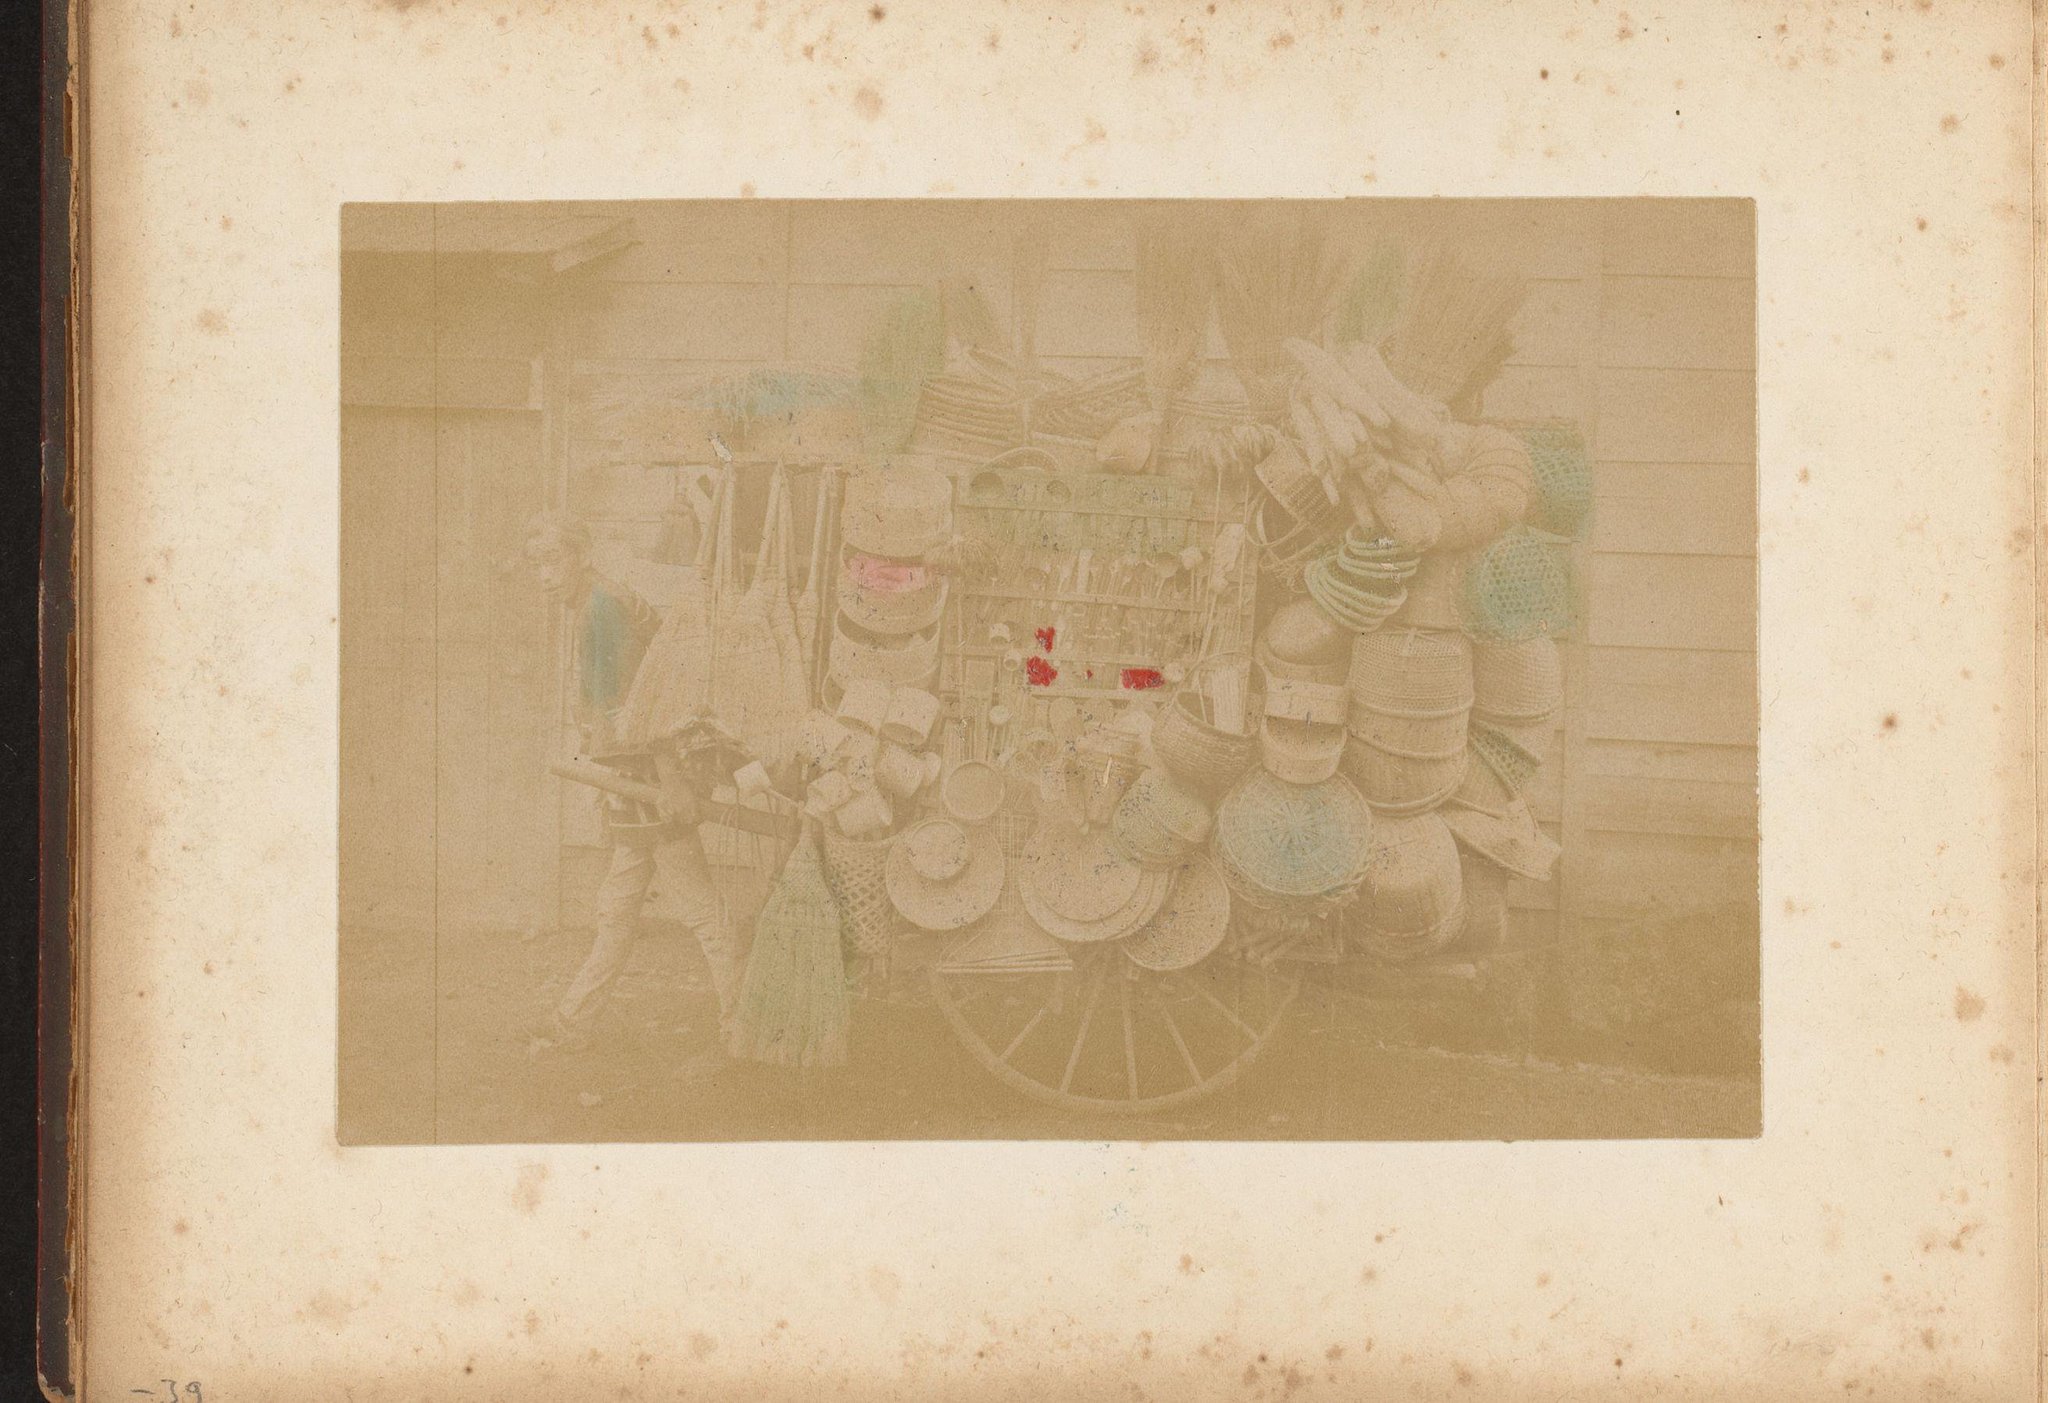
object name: album leaf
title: Man met een rijdende kraam koopwaar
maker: Anonymous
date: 1851-1900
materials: paper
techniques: albumen print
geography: japan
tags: merchant, salesman, japan